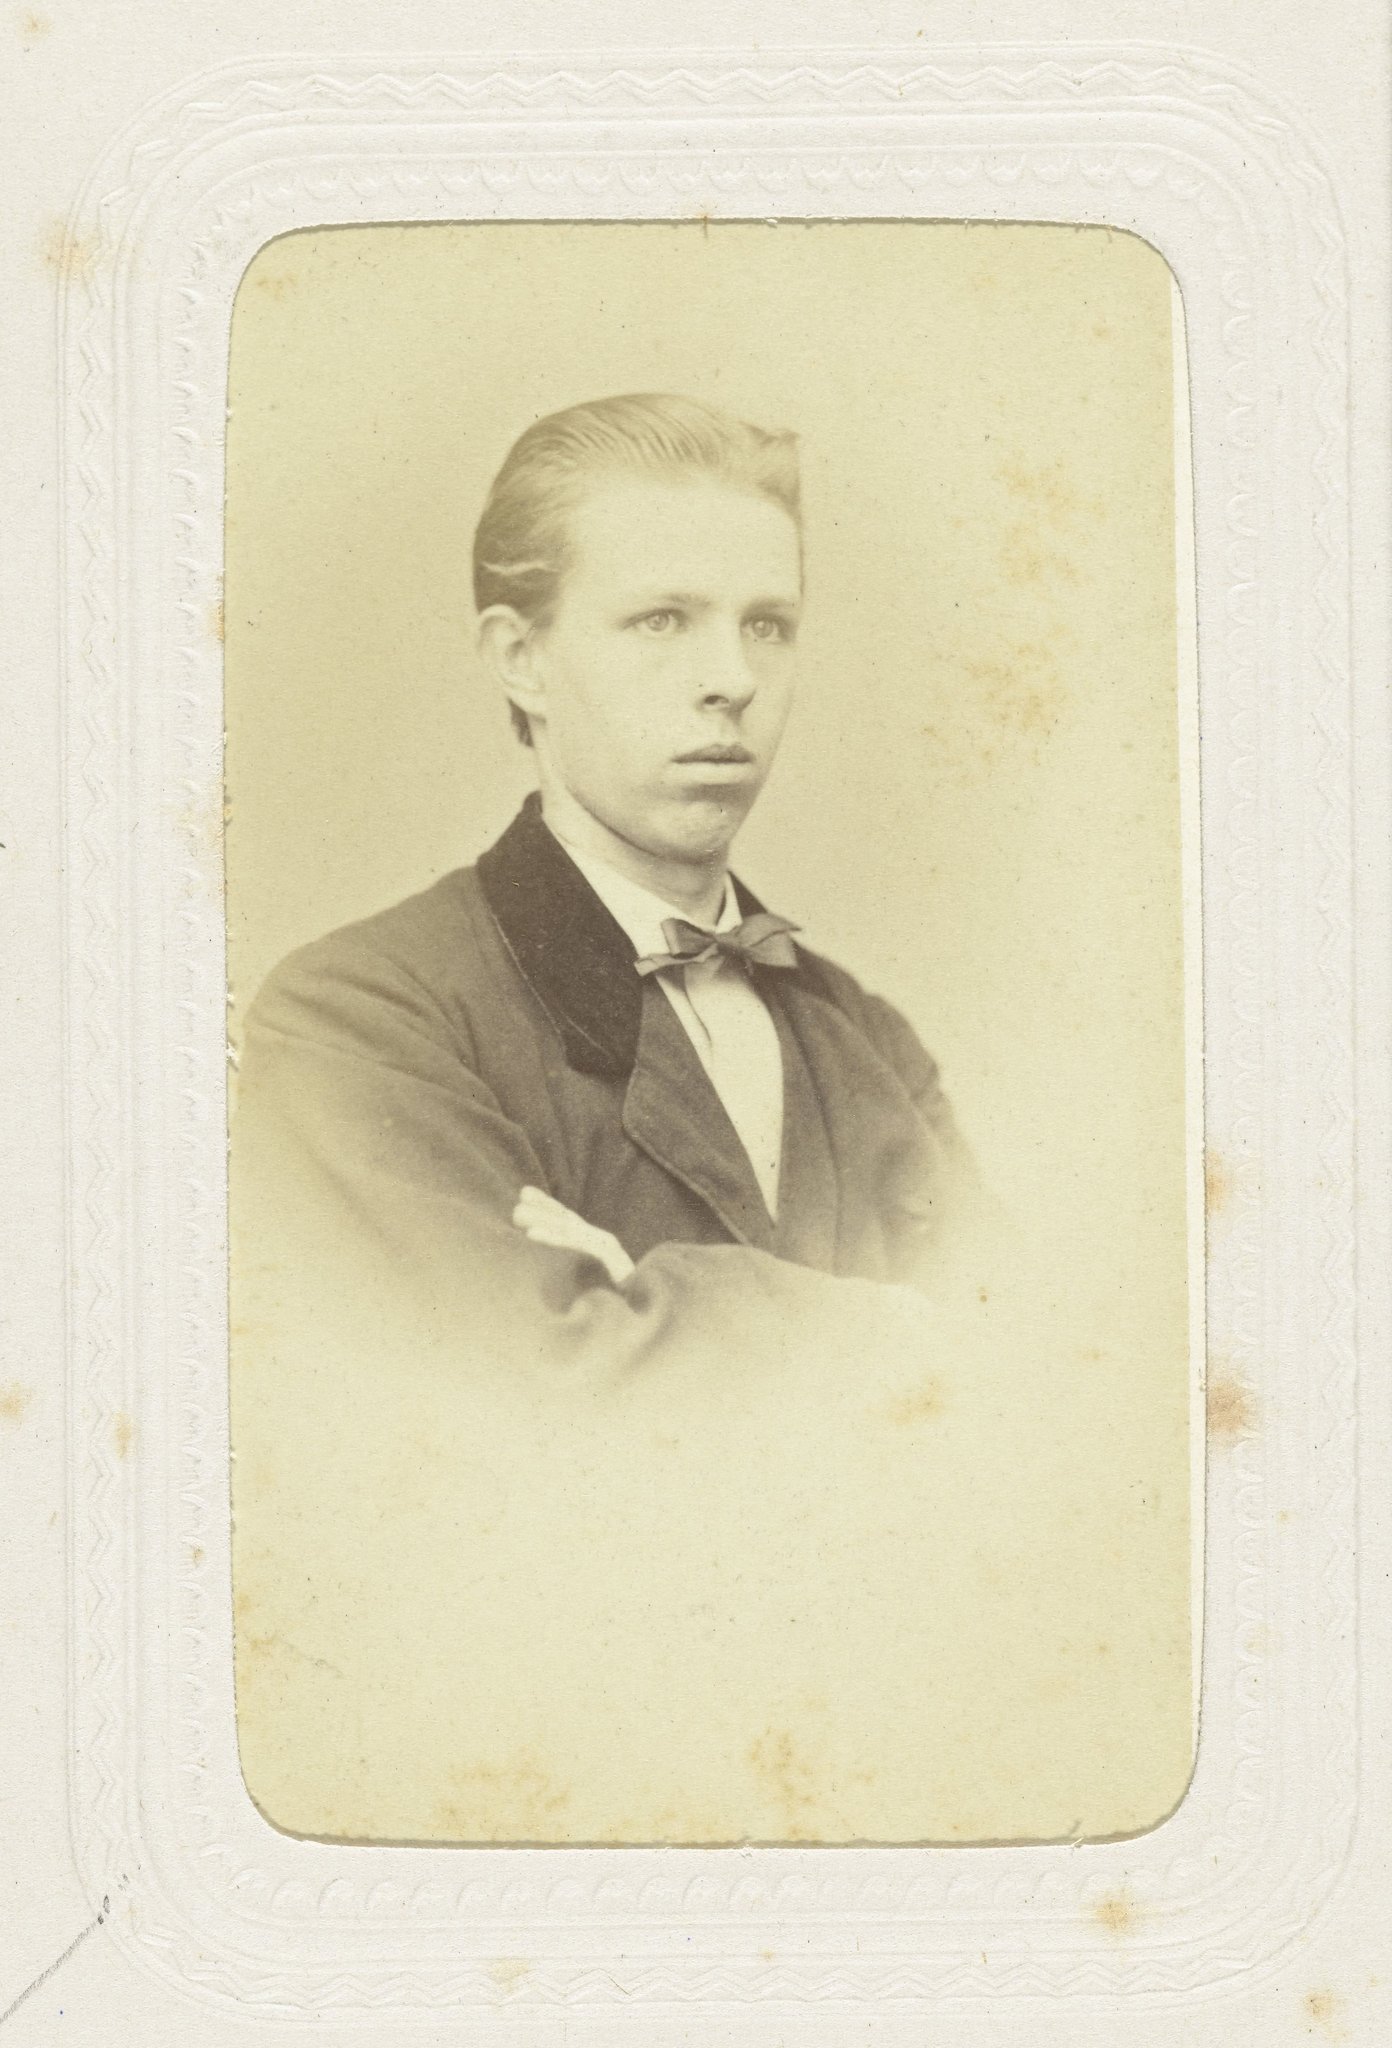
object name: carte de visite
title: Studioportret van een jongeman in een colbert met een fluwelen kraag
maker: albert greiner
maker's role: fotograaf, fotostudio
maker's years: 1833-1890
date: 1863-1866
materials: cardboard, paper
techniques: albumen print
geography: amsterdam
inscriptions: name: ‘Albert Greiner Amsterdam’